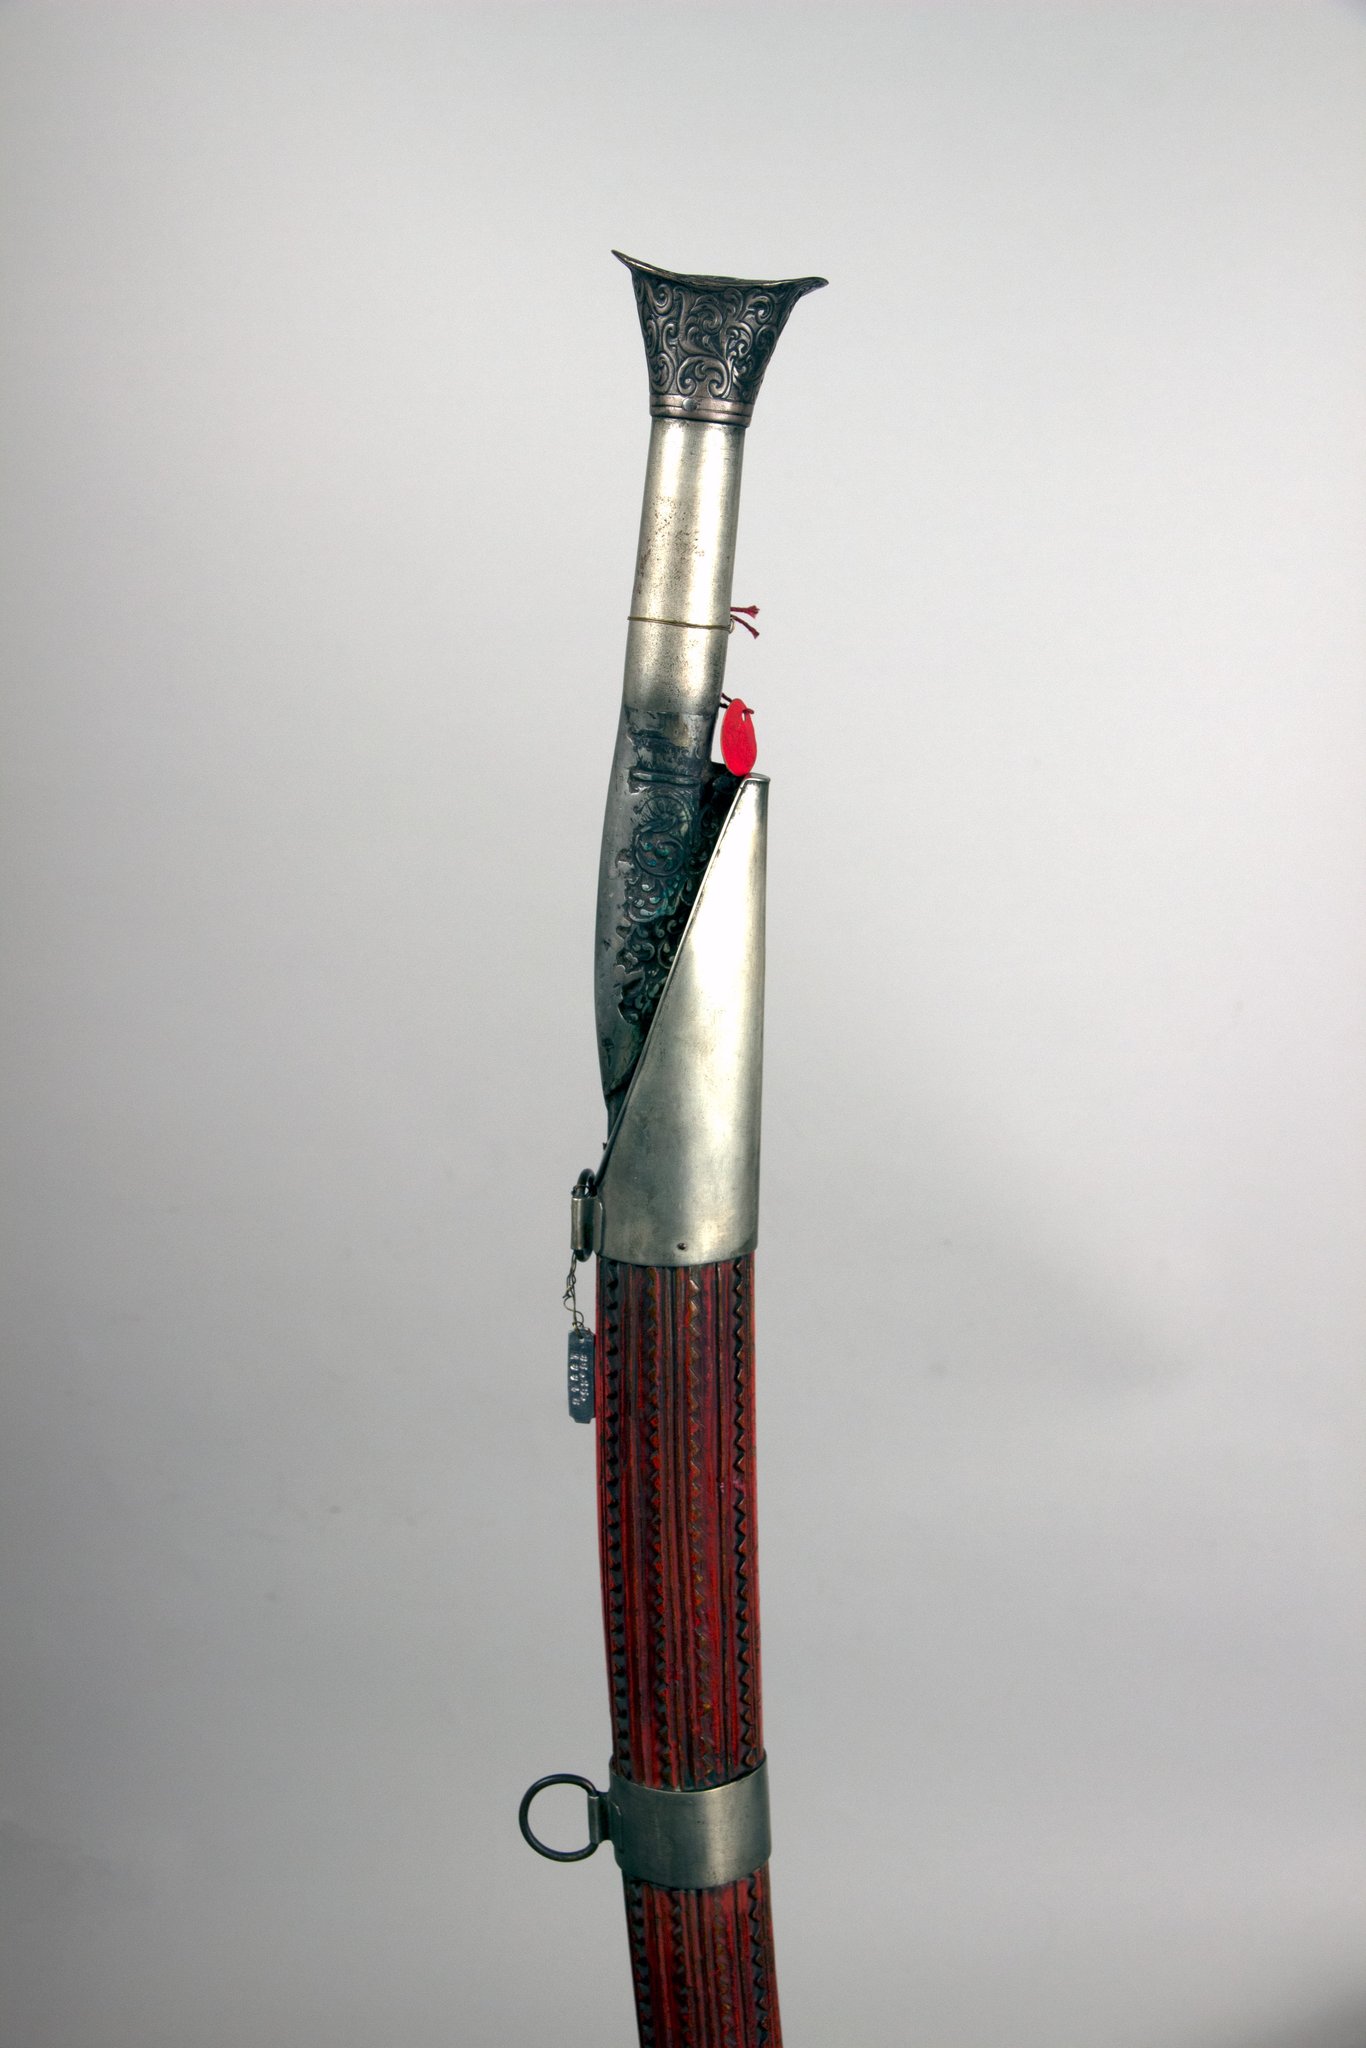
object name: sword yatagan with scabbard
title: Sword (Yatagan) with Scabbard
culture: turkish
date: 1801-1900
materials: lacquer, silver, steel, wood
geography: ottoman empire